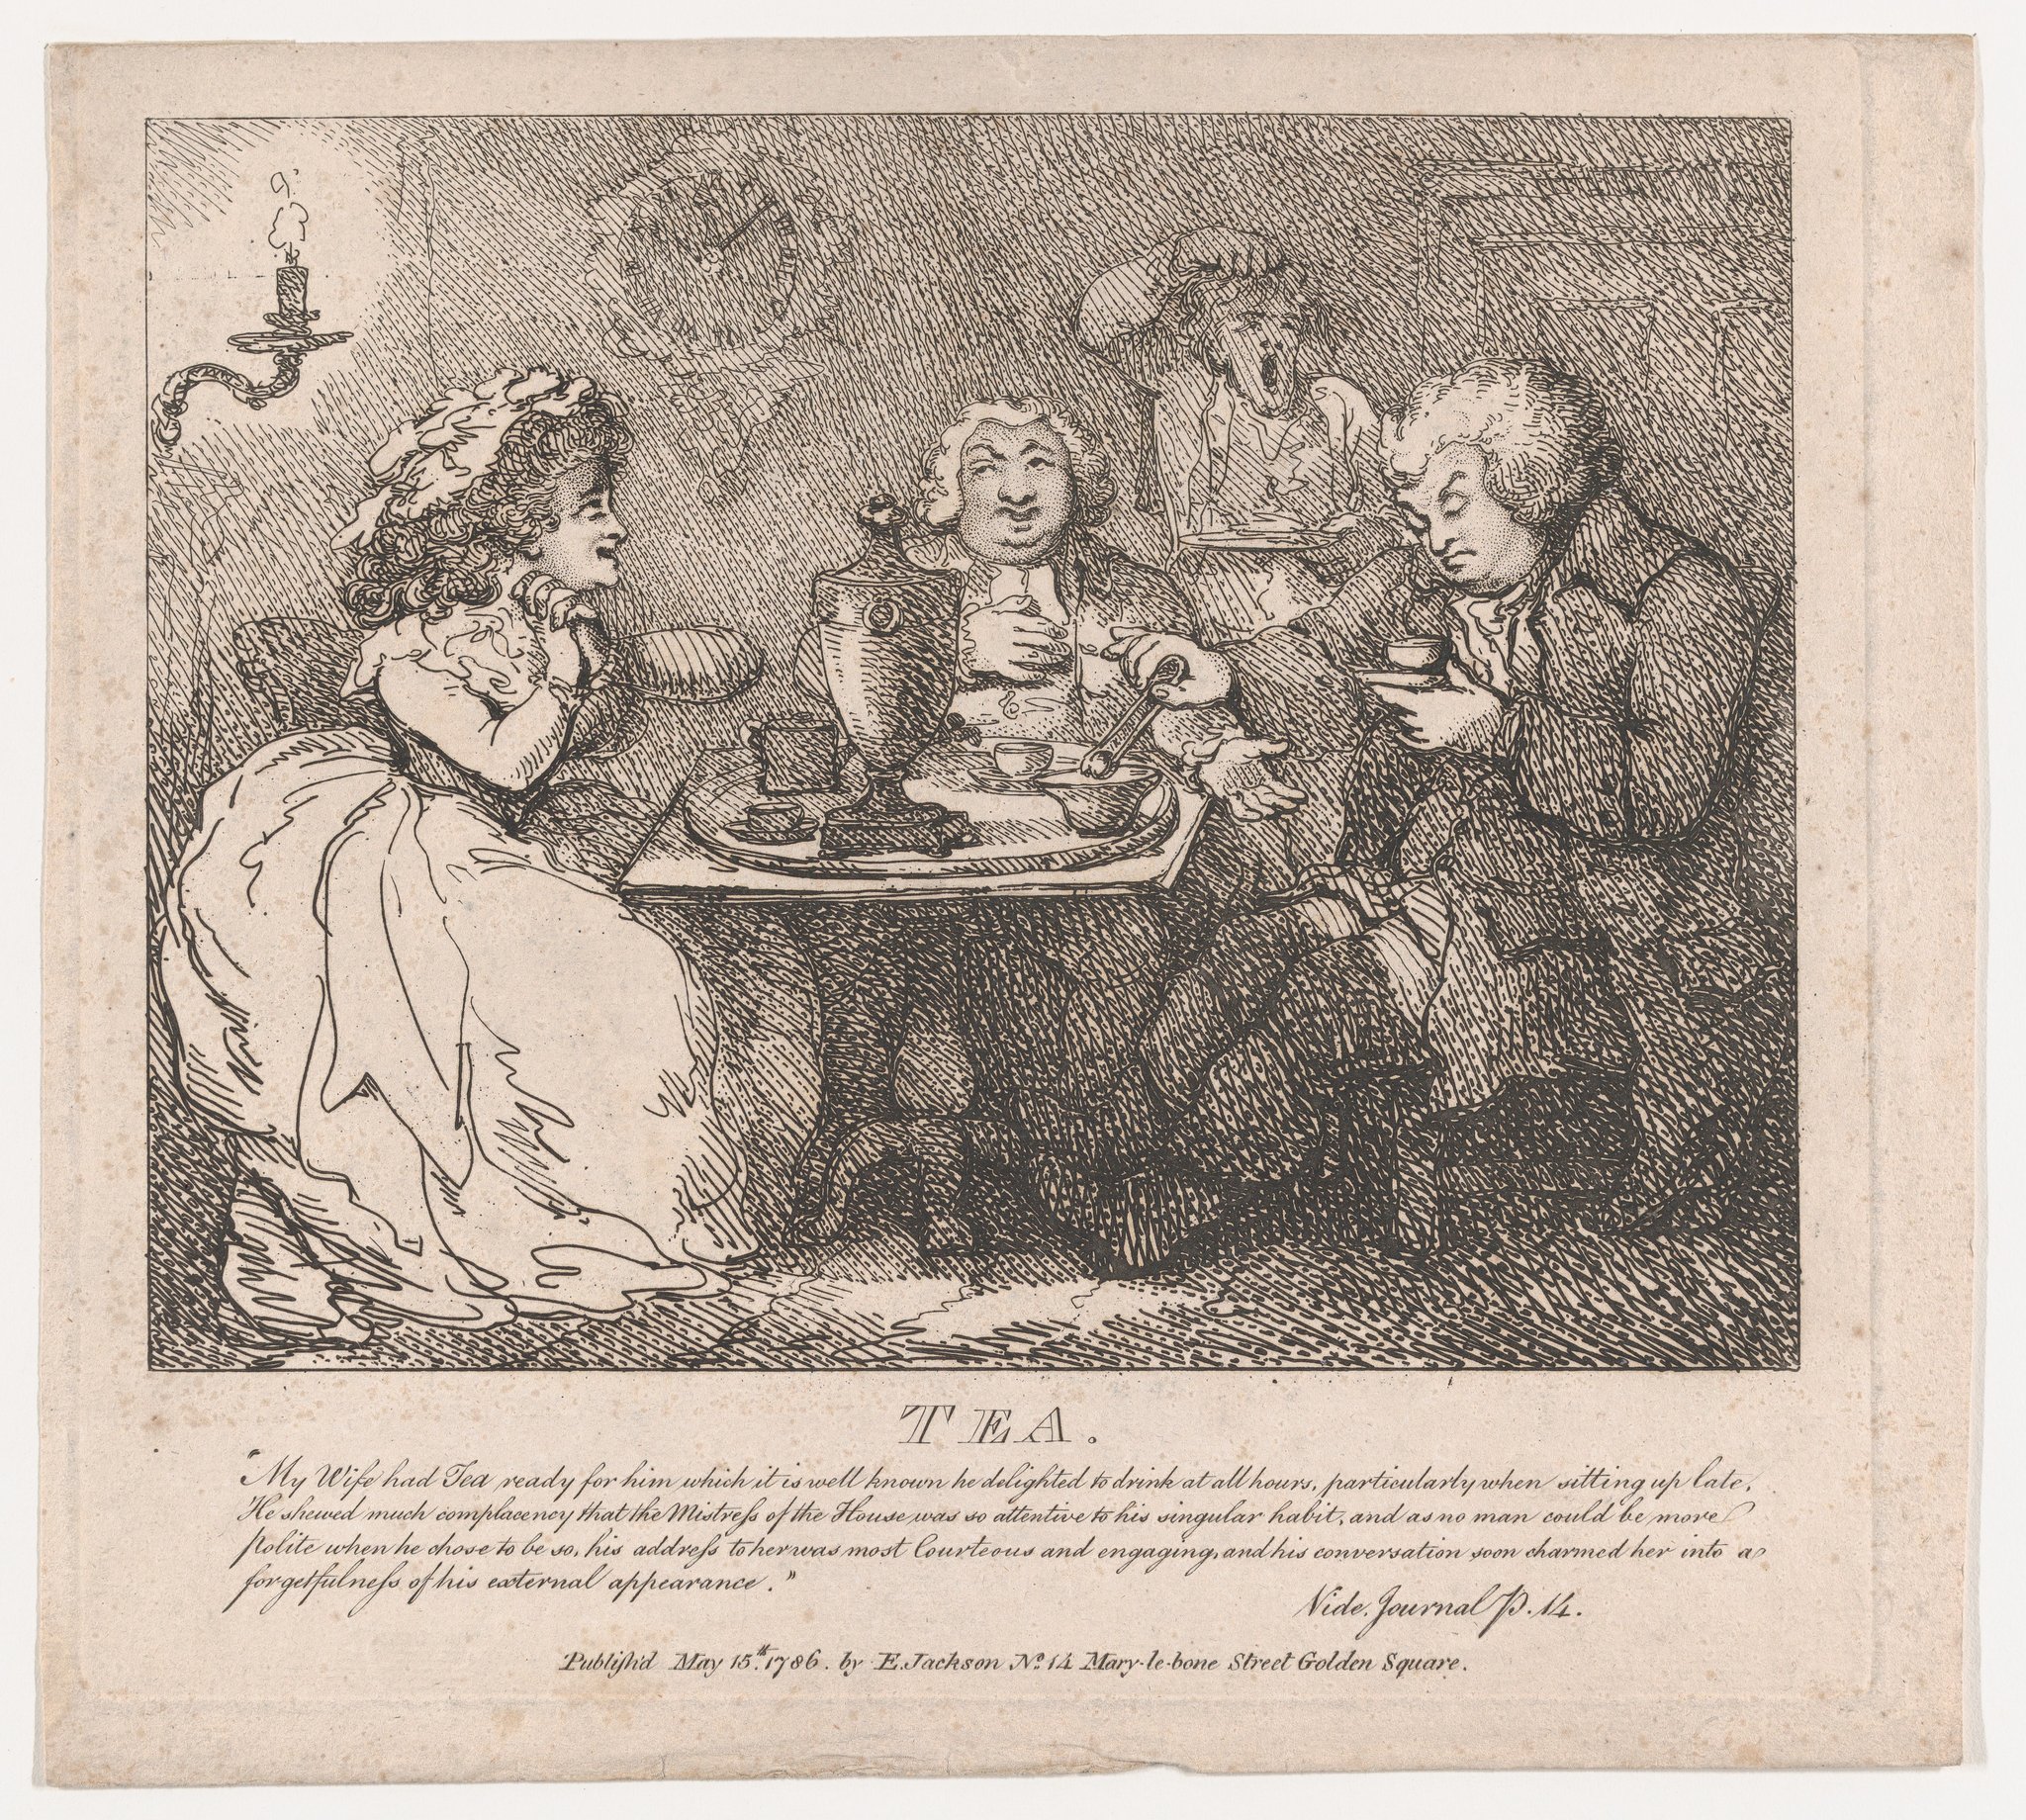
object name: print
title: Tea (Picturesque Beauties of Boswell, Part the First)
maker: thomas rowlandson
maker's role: artist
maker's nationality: british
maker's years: 1757-1827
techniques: etching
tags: men,women,tables